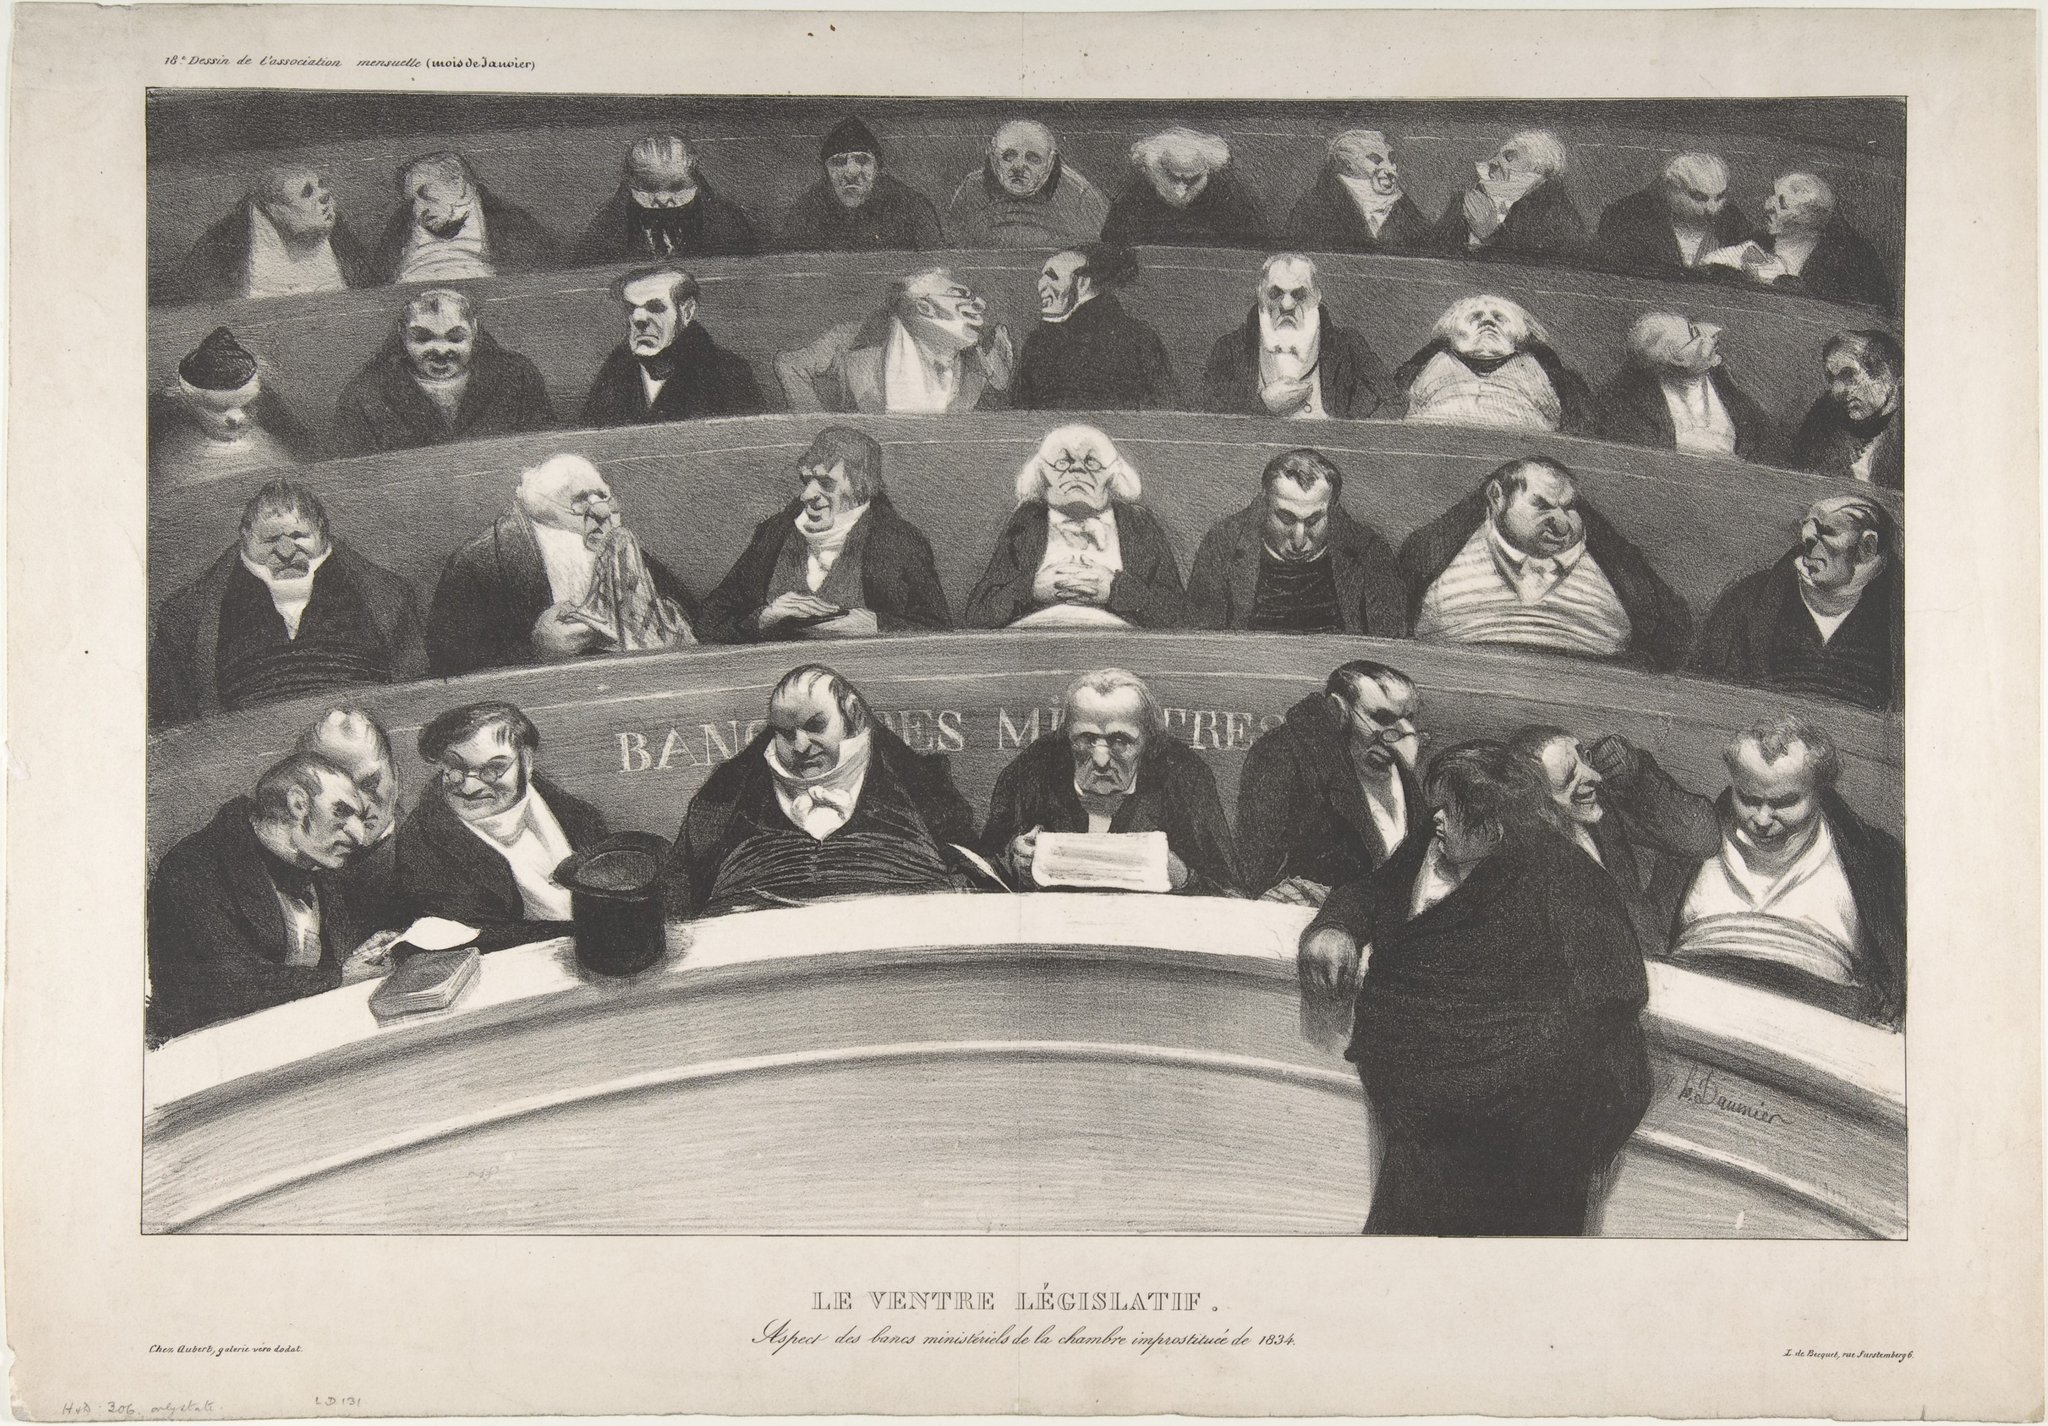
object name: print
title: The Legislative Belly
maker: honoré daumier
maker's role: artist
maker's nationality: french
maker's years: 1808-1879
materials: paper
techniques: lithograph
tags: government,men